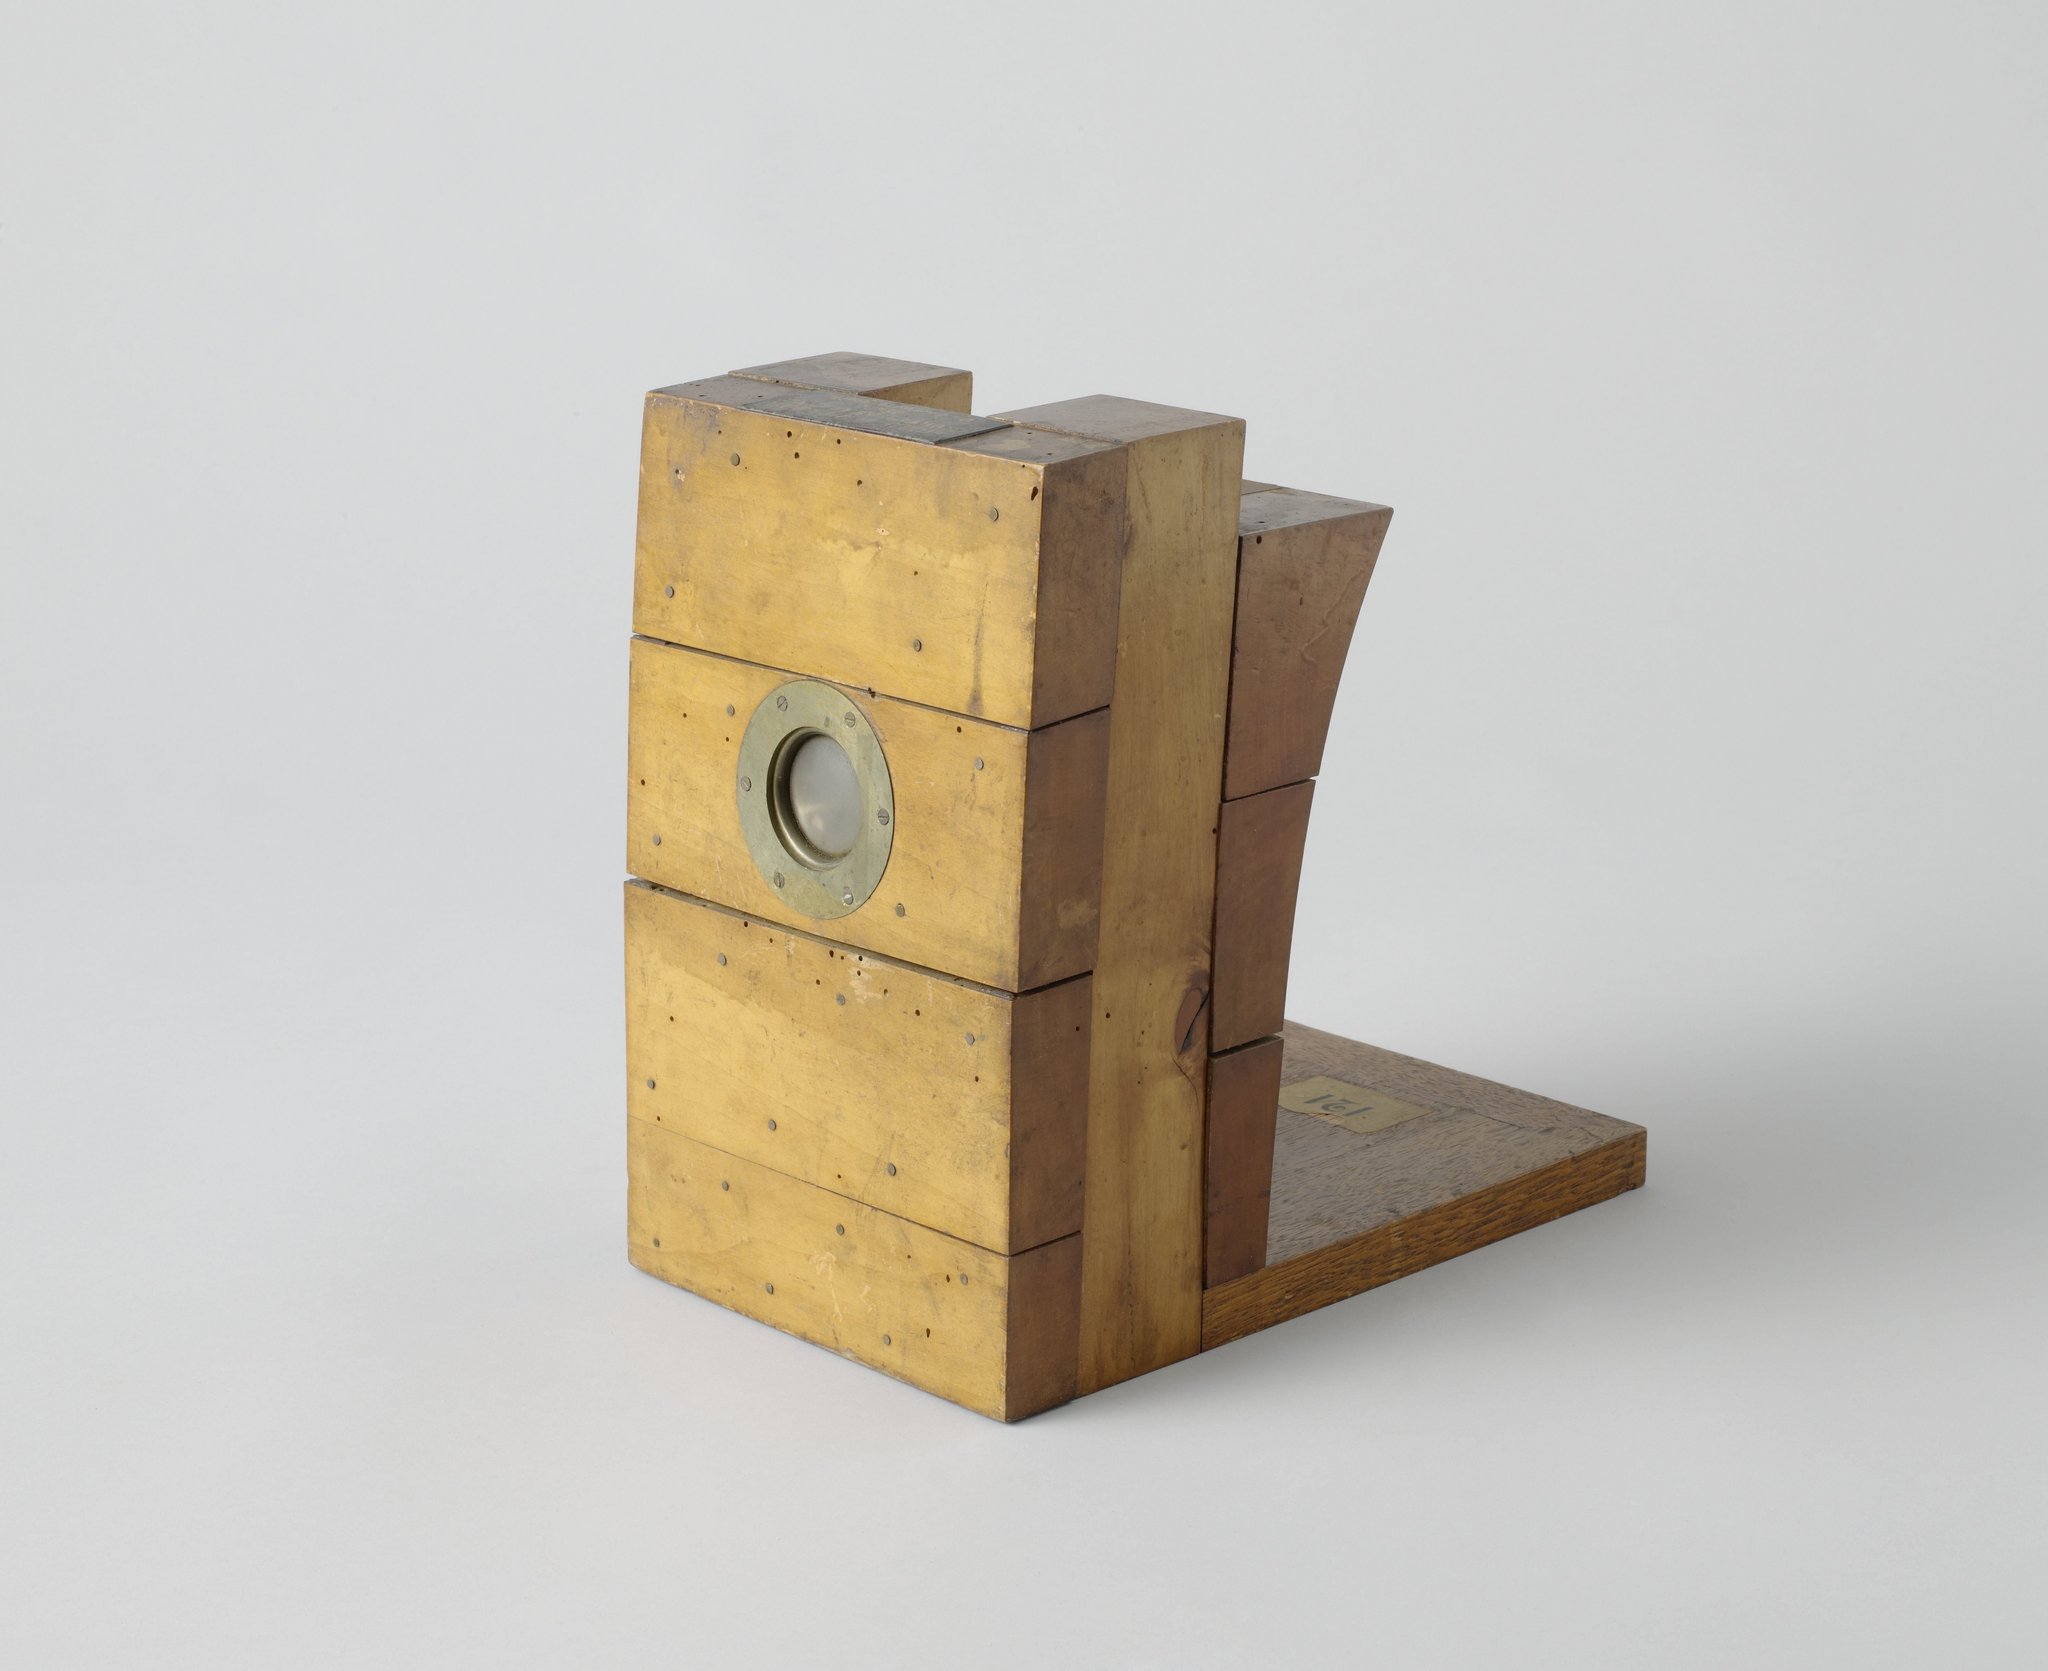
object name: demonstration model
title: Model of a Ventilating Shaft and Portlight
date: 1849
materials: brass, glass, wood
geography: flushing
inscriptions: inscription, top centre: ‘LICHT- en LUCHTKOKER / (KORVET ATALANTE) / 1849. / Op 1/4 der ware grootte. Ingezonden in voldoening / van de Resolutie van 21 Sep- / tember 1849 D N 63 door den / Hoofd Ingenieur der Marine / A.[...] Bruyn’, label, on the base: ‘121’ former inventory label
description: Model van een lucht- en lichtkoker. Model van een deel van een scheepswand, op een grondplank. De scheepswand bestaat uit de huid, twee inhouten en de wegering; de ruimte tussen de inhouten is de luchtkoker, voorzien van een rooster. De luchtkoker komt uit in een diepe conische patrijspoort, die geheel met messing is bekleed. Het licht van de patrijspoort bestaat uit een rond glas met de bolle, matte kant naar buiten en in de huid verzonken. Schaal 1:4 (schaal op model).